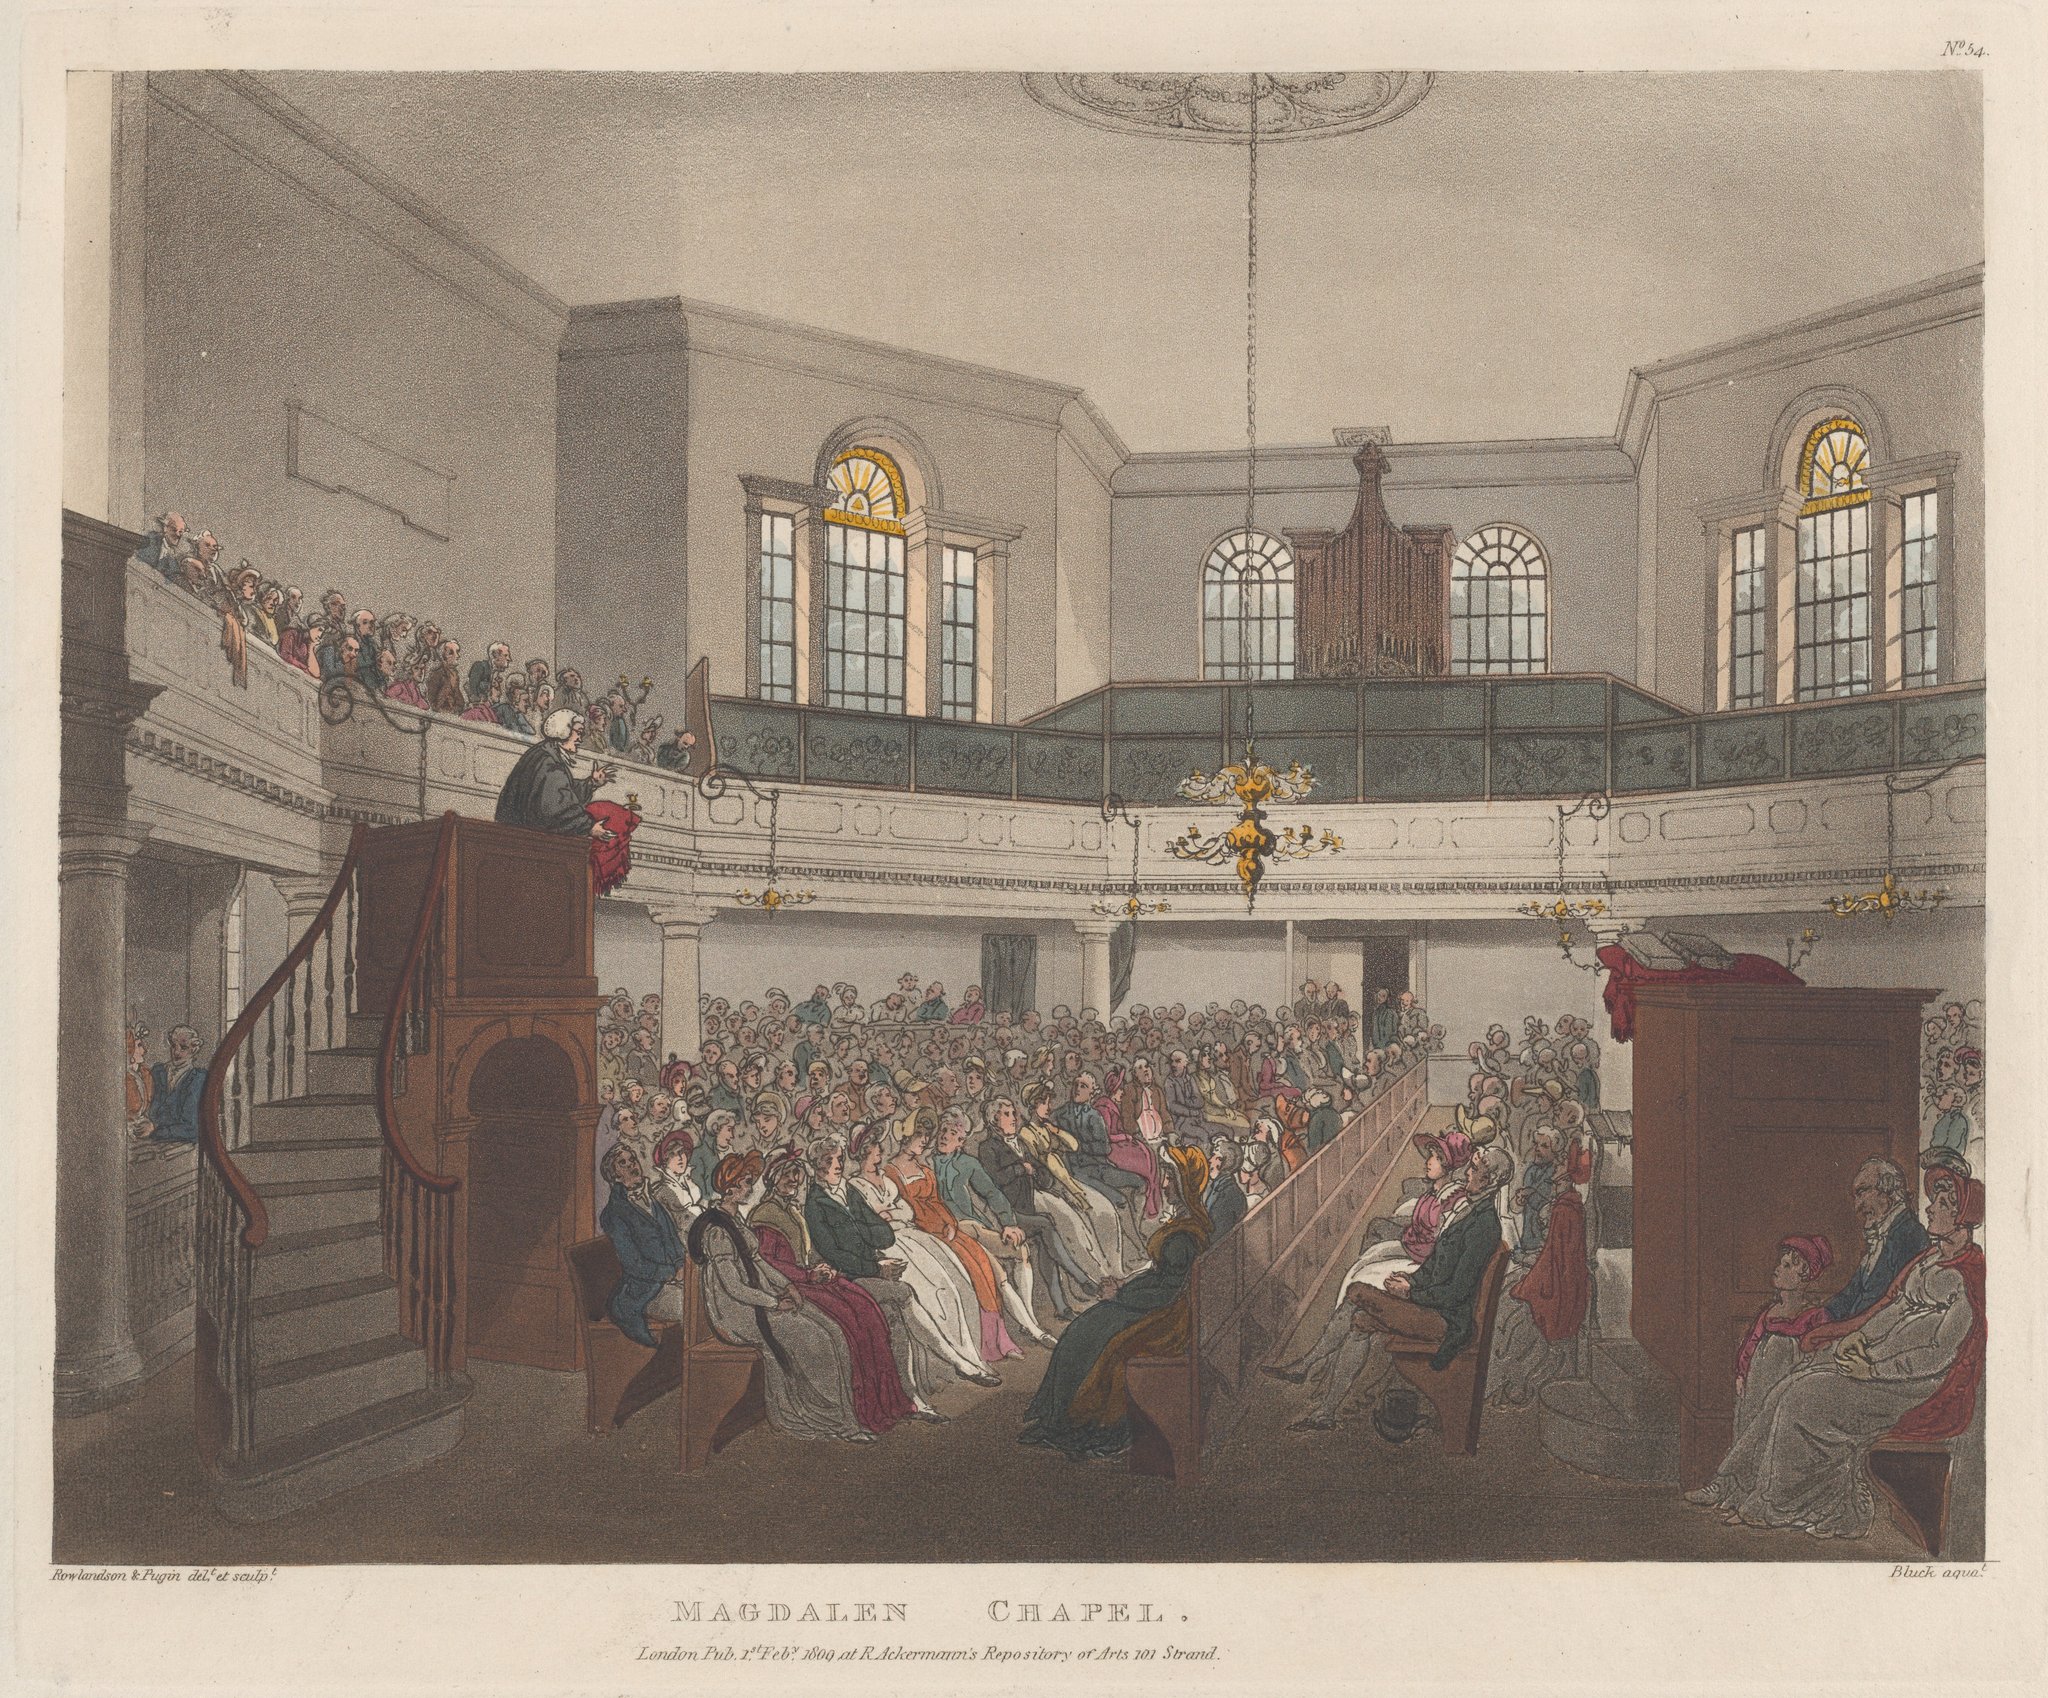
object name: print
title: Magdalen Chapel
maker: thomas rowlandson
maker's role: artist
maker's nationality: british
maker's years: 1757-1827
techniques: aquatint, etching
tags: interiors,chapels